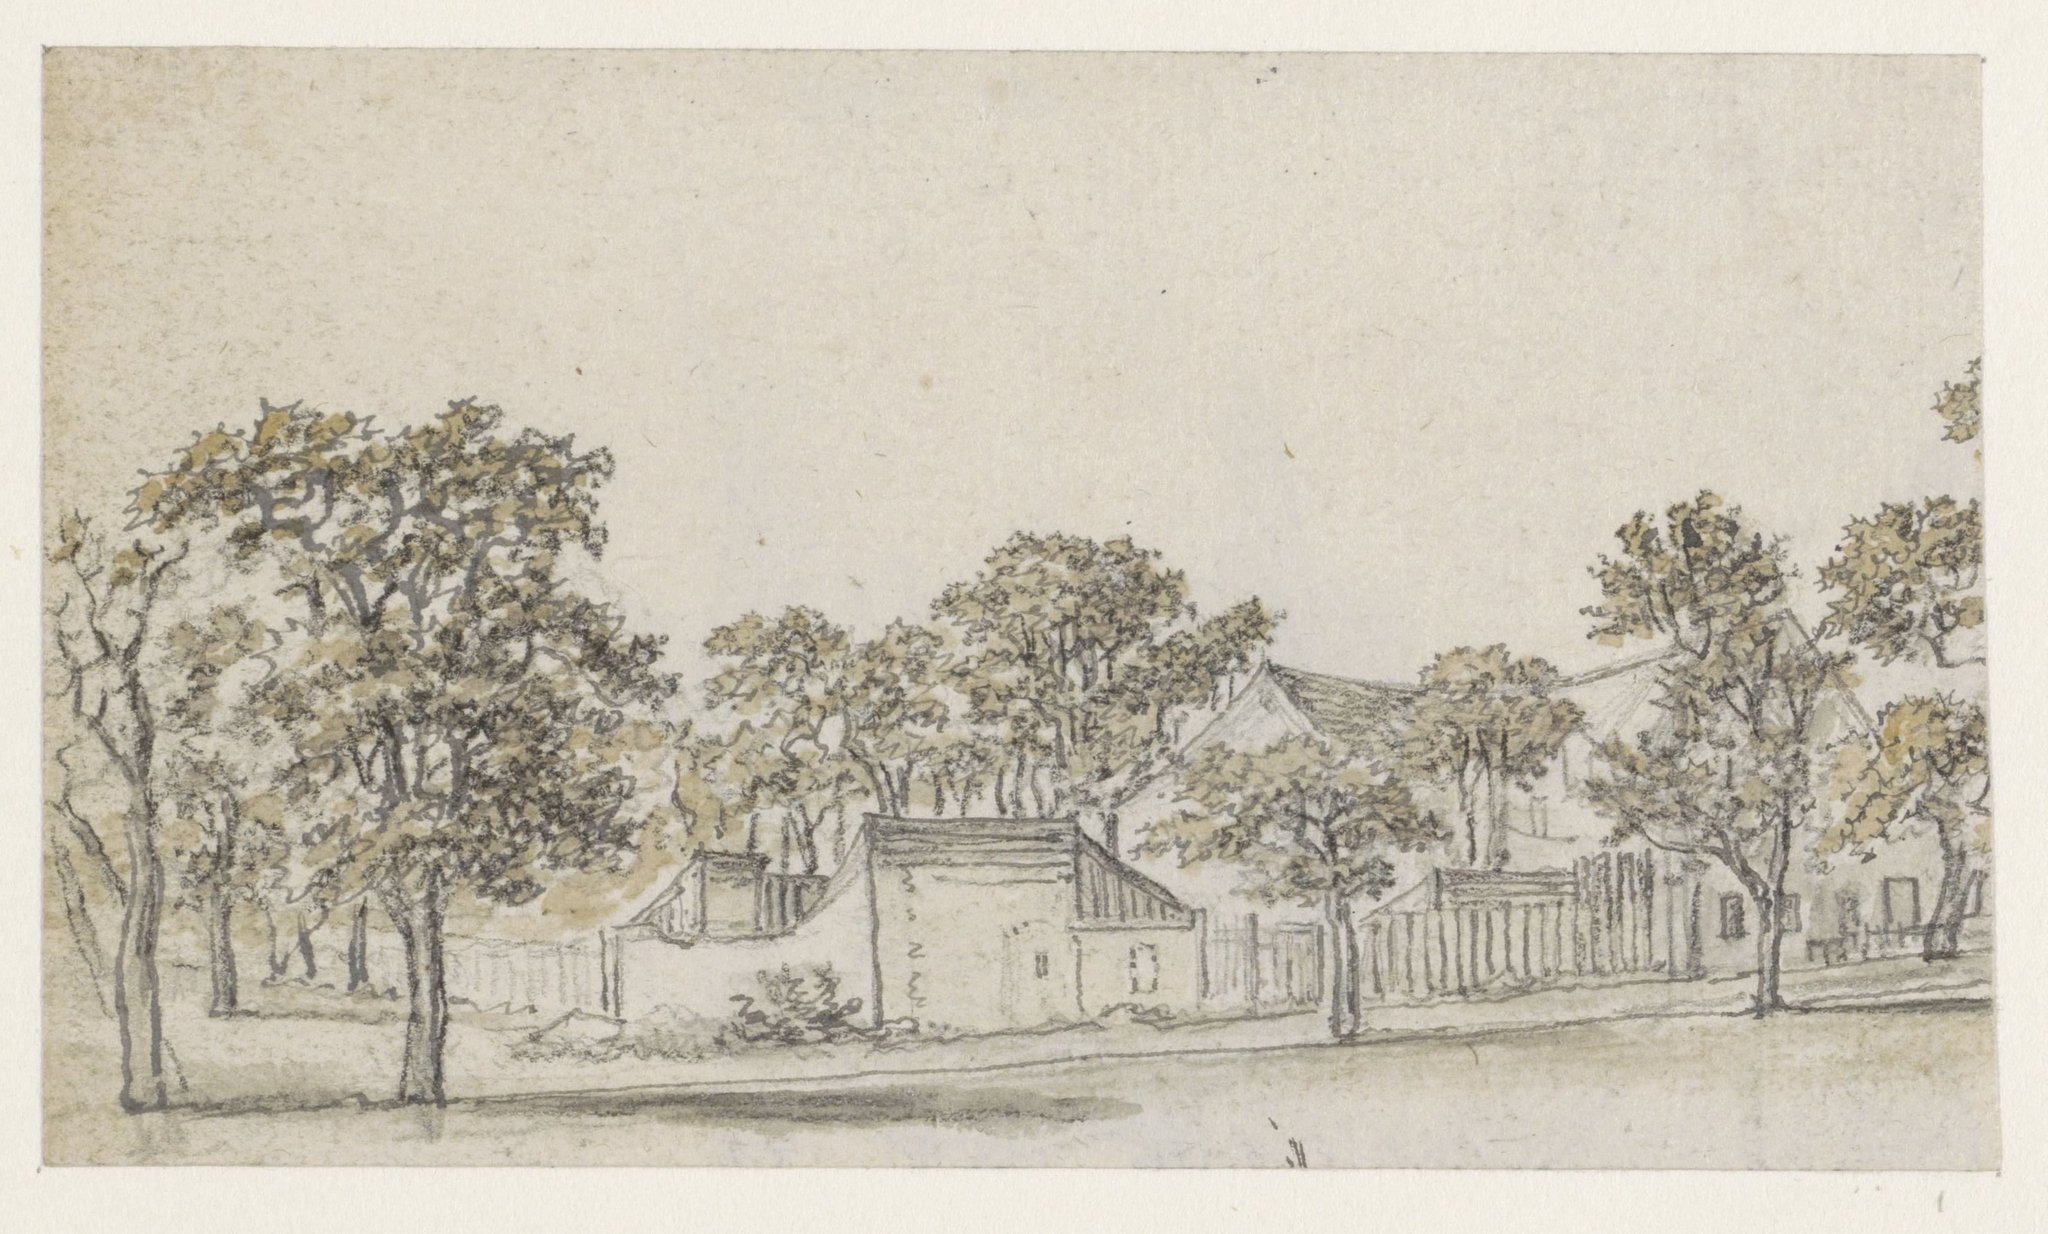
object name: drawing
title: Groep huizen tussen bomen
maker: georges michel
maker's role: draughtsman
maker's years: 1763-1843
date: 1773-1843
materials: chalk, ink, paper, pencil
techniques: brush, pen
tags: prospect of village, silhouette of village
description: Een van 120 tekeningen, afkomstig uit een 19e eeuws album met tekeningen van Georges Michel.